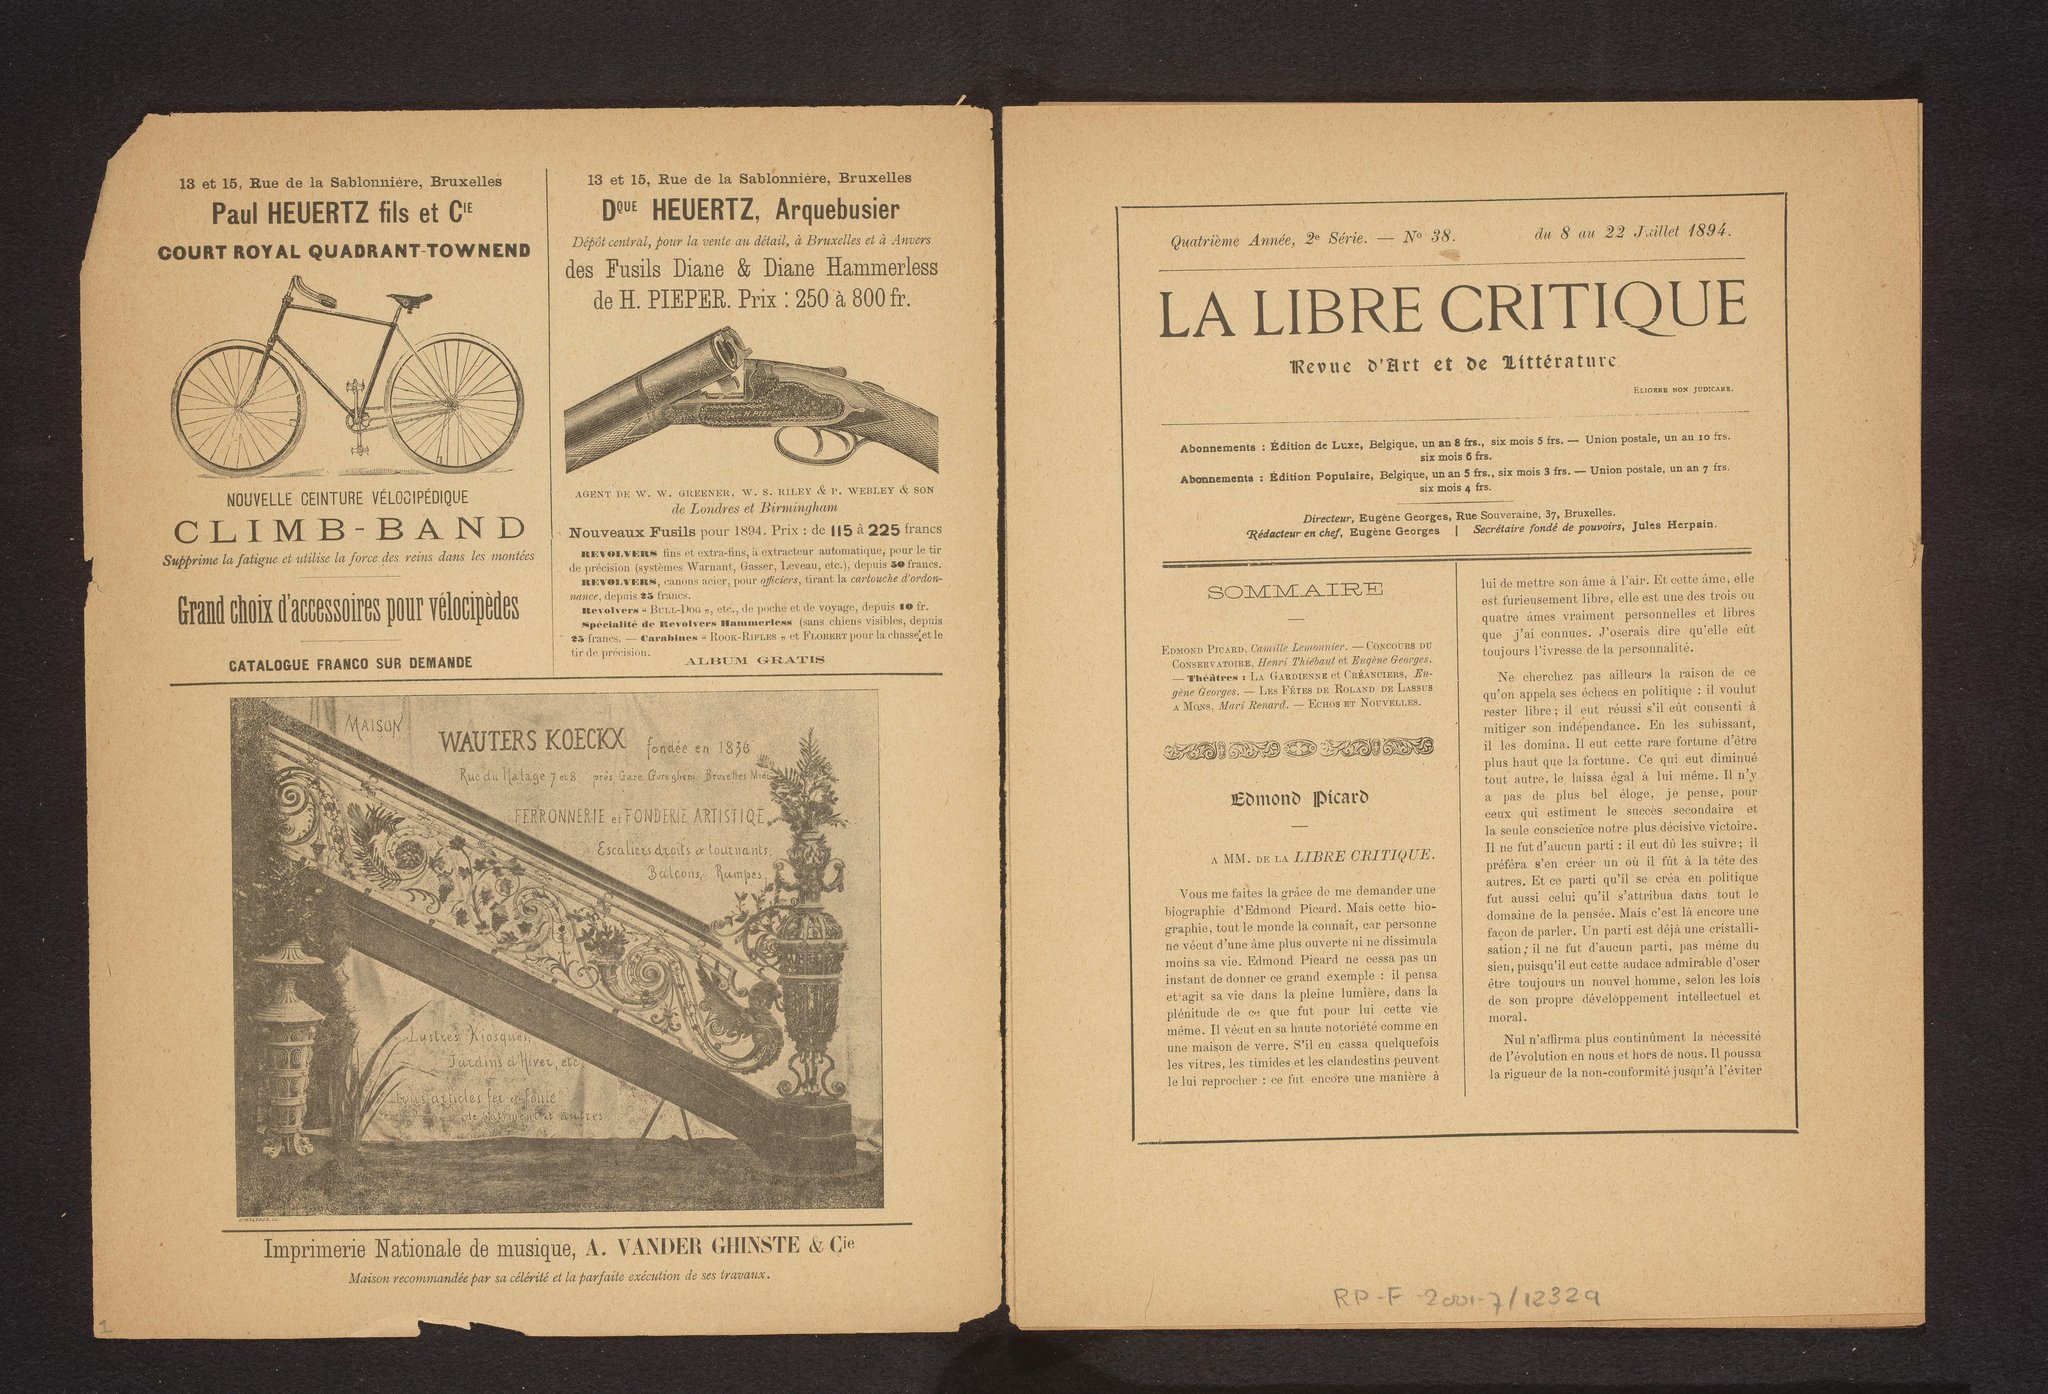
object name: book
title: La libre critique revue d'art et de littérature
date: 1894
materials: paper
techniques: photograph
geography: brussels